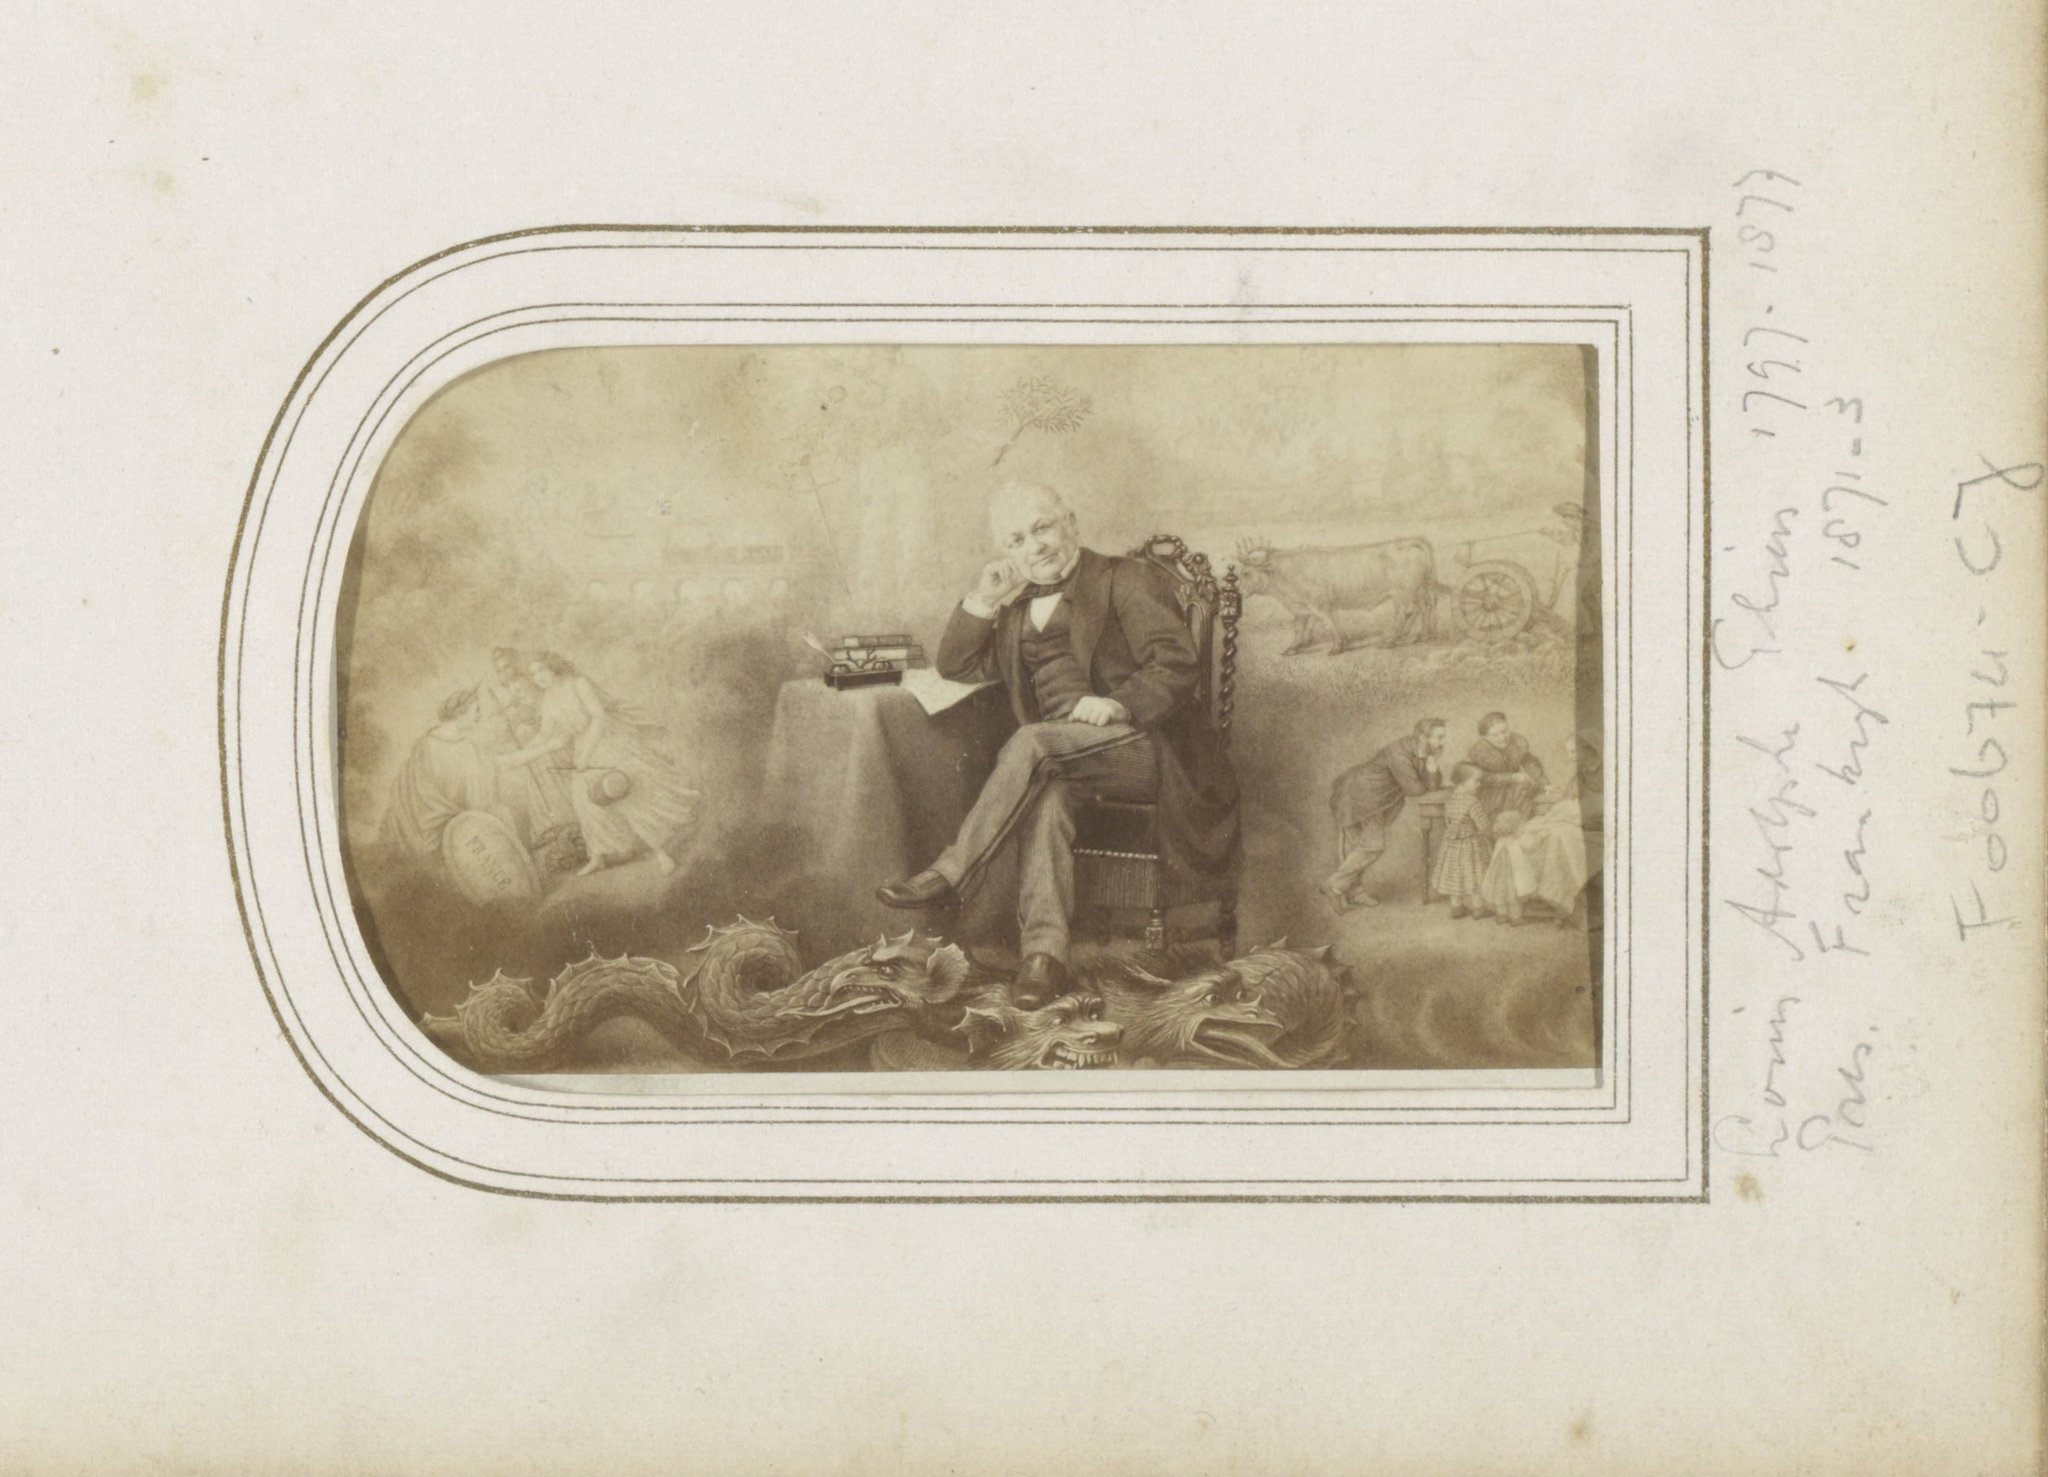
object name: carte de visite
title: La France en Paix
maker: étienne neurdein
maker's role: publisher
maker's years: 1832-1918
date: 1863-1880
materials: cardboard, paper, photographic support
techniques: albumen print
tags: politician, eyeglasses, spectacles, trousers, breeches, painting (including book-illumination, miniature-painting) (+ plaster ~ arts), historical persons, clothing for the upper part of the body, politician, e.g. party leader, dragon, picture, painting, political caricatures and satires, coat, cape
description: Portret van Louis-Adolphe Thiers, eerste president van de Derde Franse Republiek, zittend op een draak voor een allegorische schildering. Onderdeel van Fotoalbum met 123 cartes-de-visite van leden van Europese vorstenhuizen, politici en bekende personen.